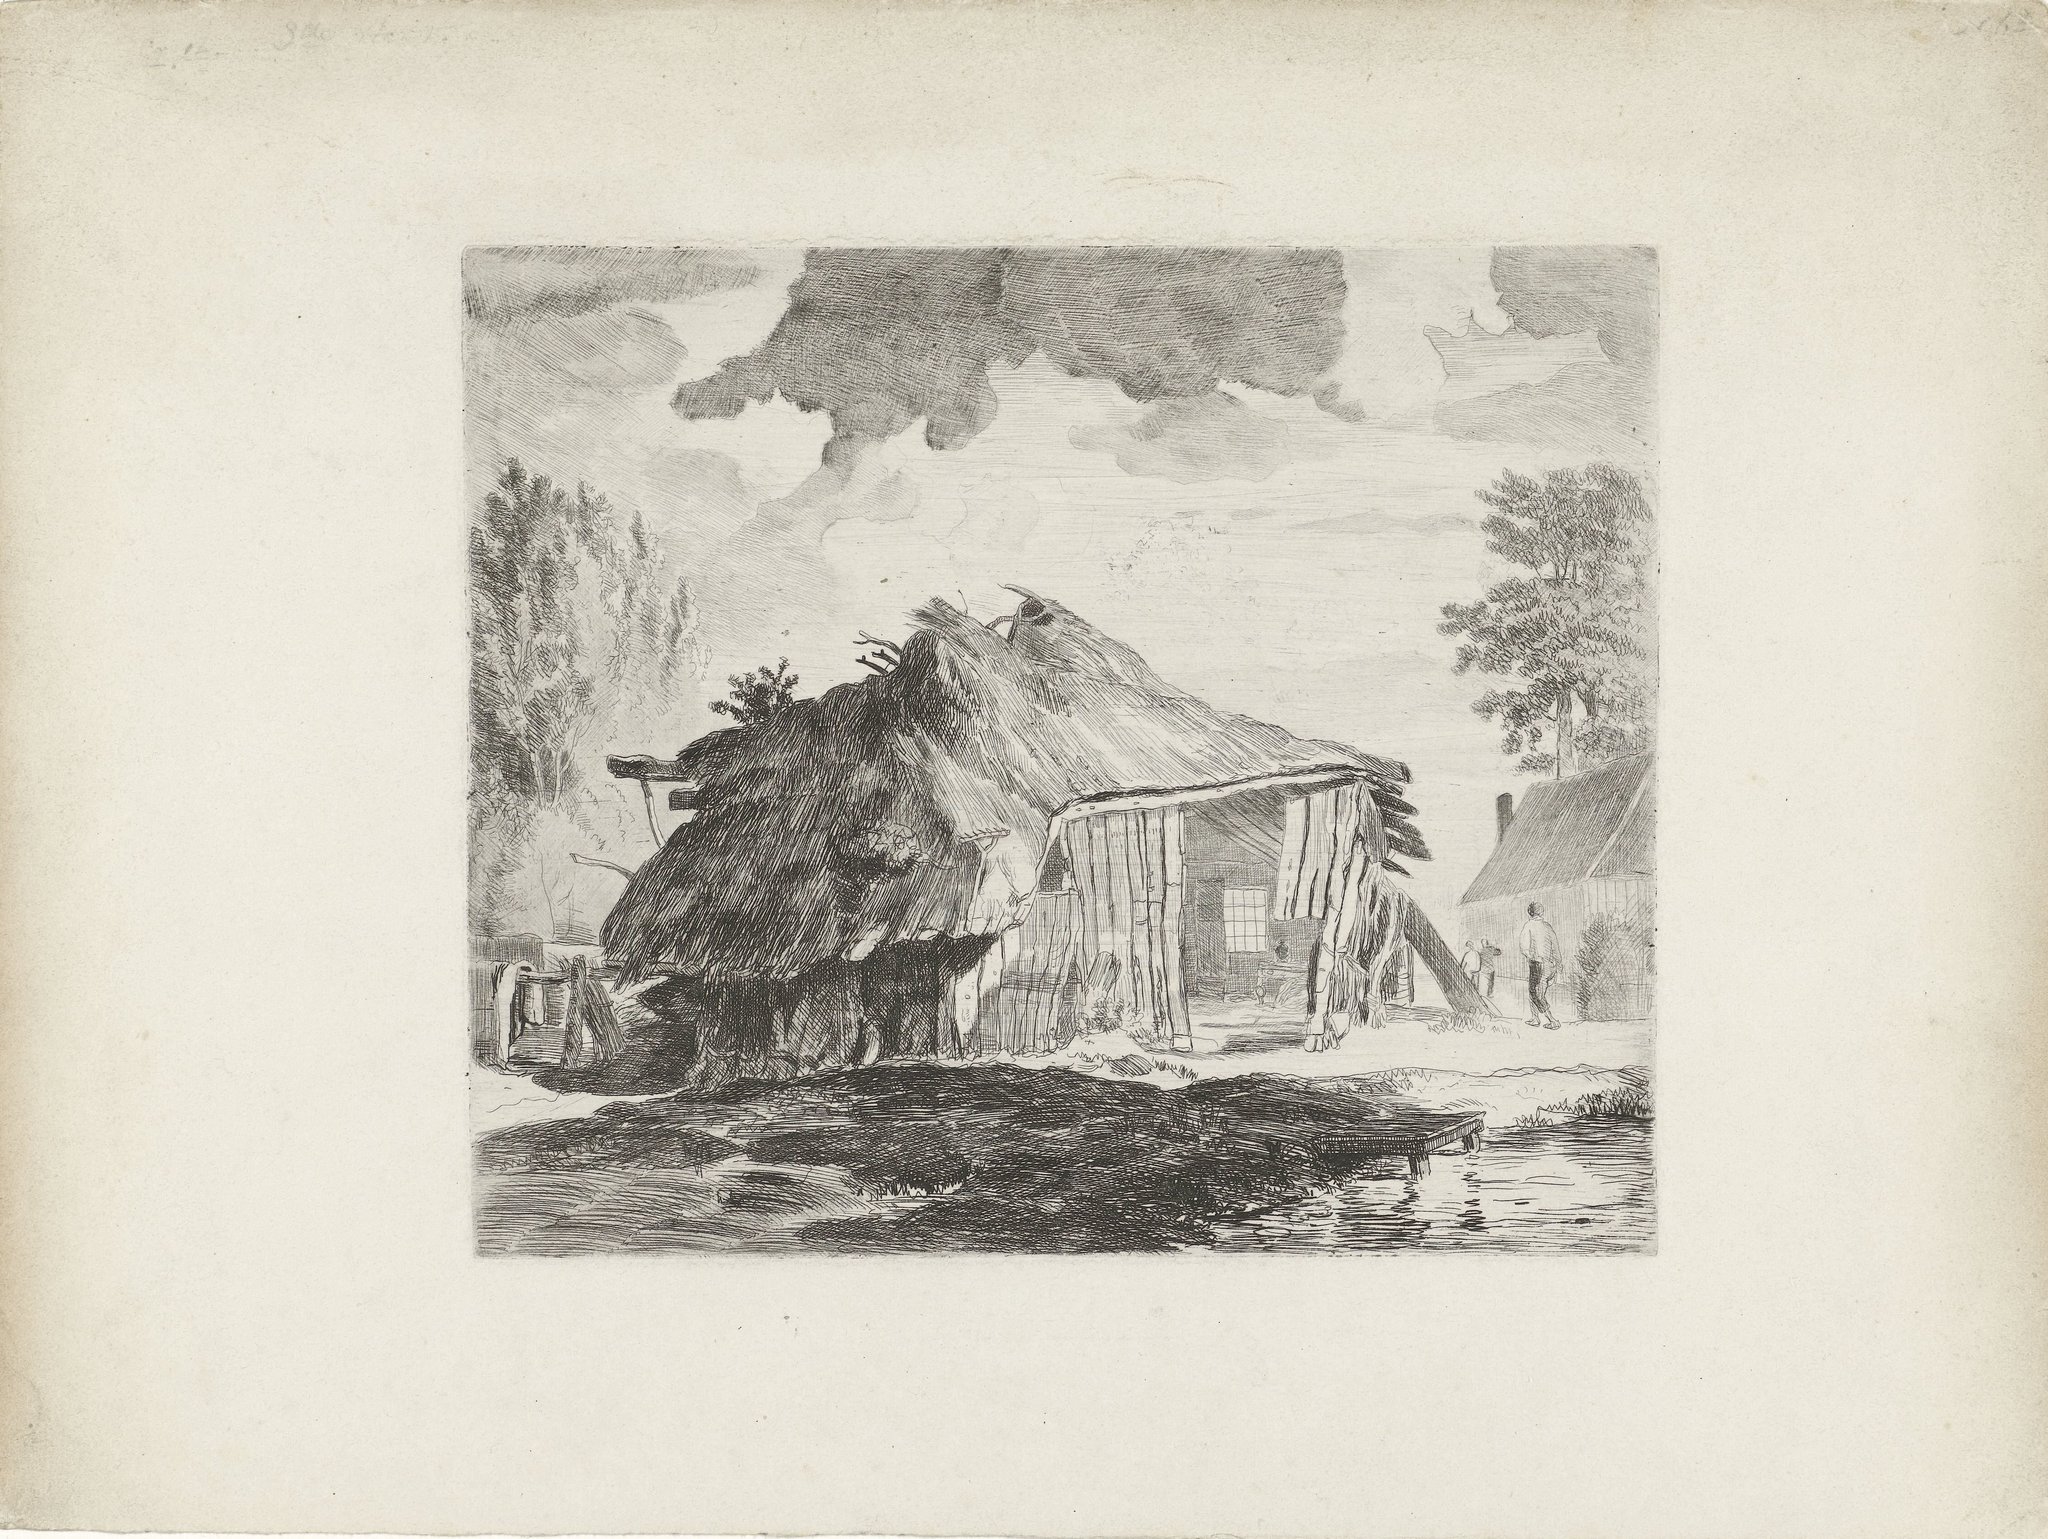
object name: print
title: Brabantsche schuur te Kaatsheuvel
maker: cornelis van der griendt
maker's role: draughtsman, painter, print maker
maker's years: 1827-1918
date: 1858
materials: paper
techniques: drypoint, etching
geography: netherlands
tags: barn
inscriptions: collector's mark: Lugt 2228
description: Schuur in een landschap aan water gelegen. Aan de rechterzijde drie figuren.